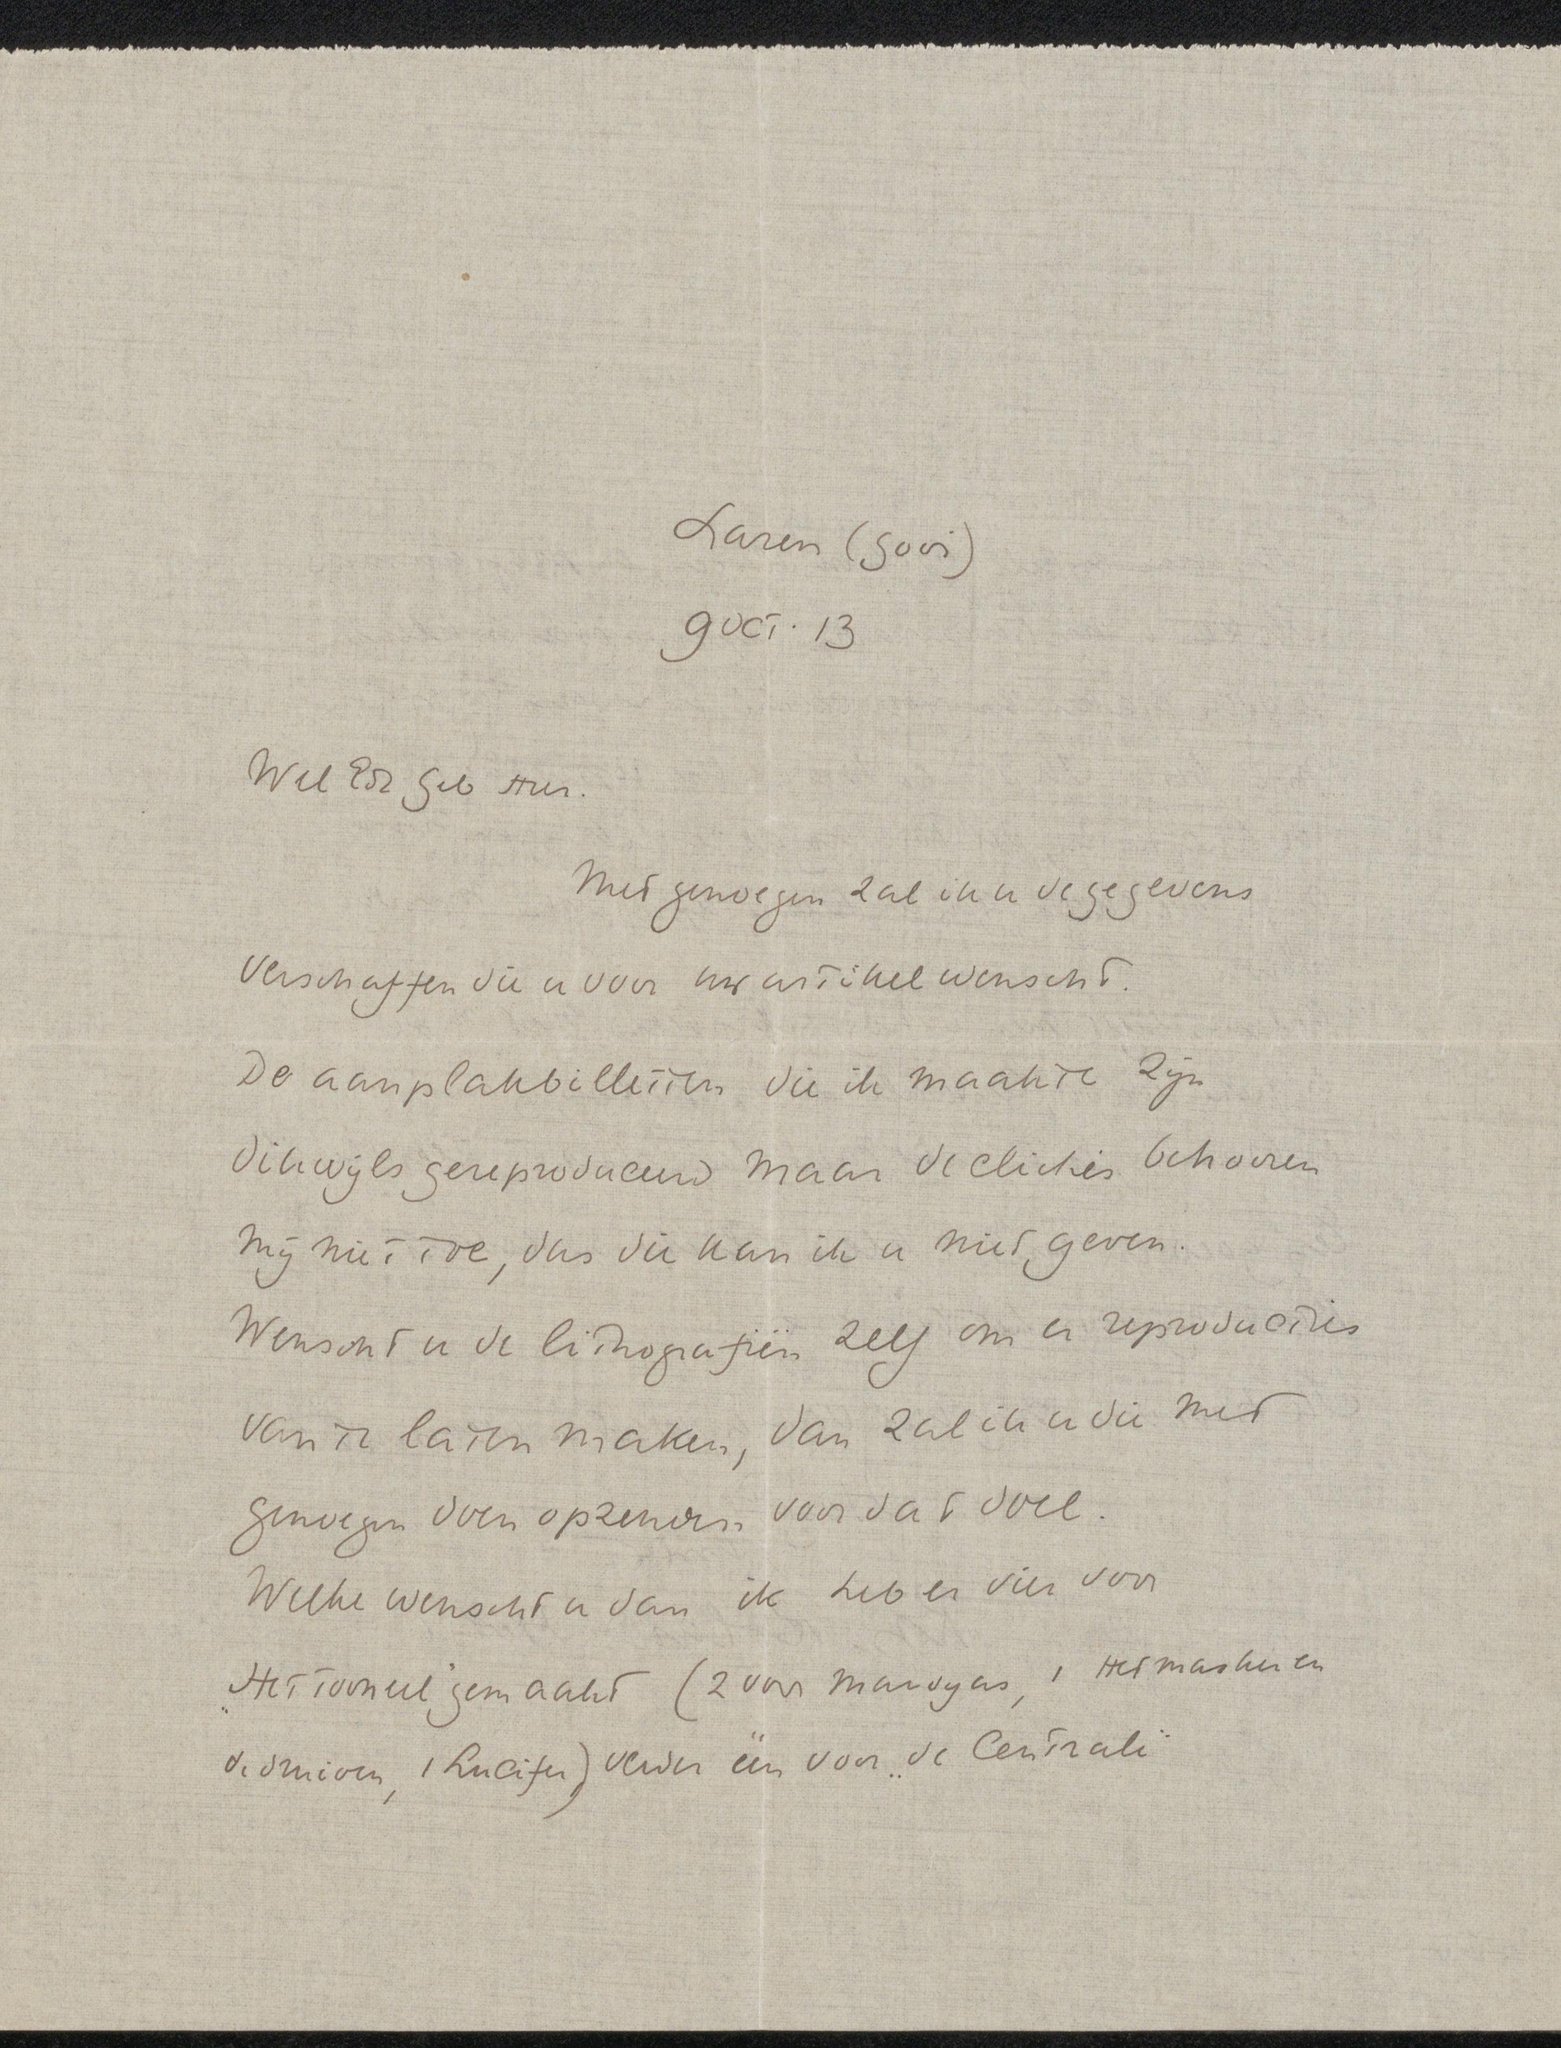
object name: letter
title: Brief aan anoniem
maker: richard nicolaüs roland holst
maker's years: 1868-1938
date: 1913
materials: ink, paper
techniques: pen, writing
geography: laren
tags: applied arts, arts and crafts; industrial design, the graphic arts, printed matter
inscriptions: collector's mark: ‘RPK’